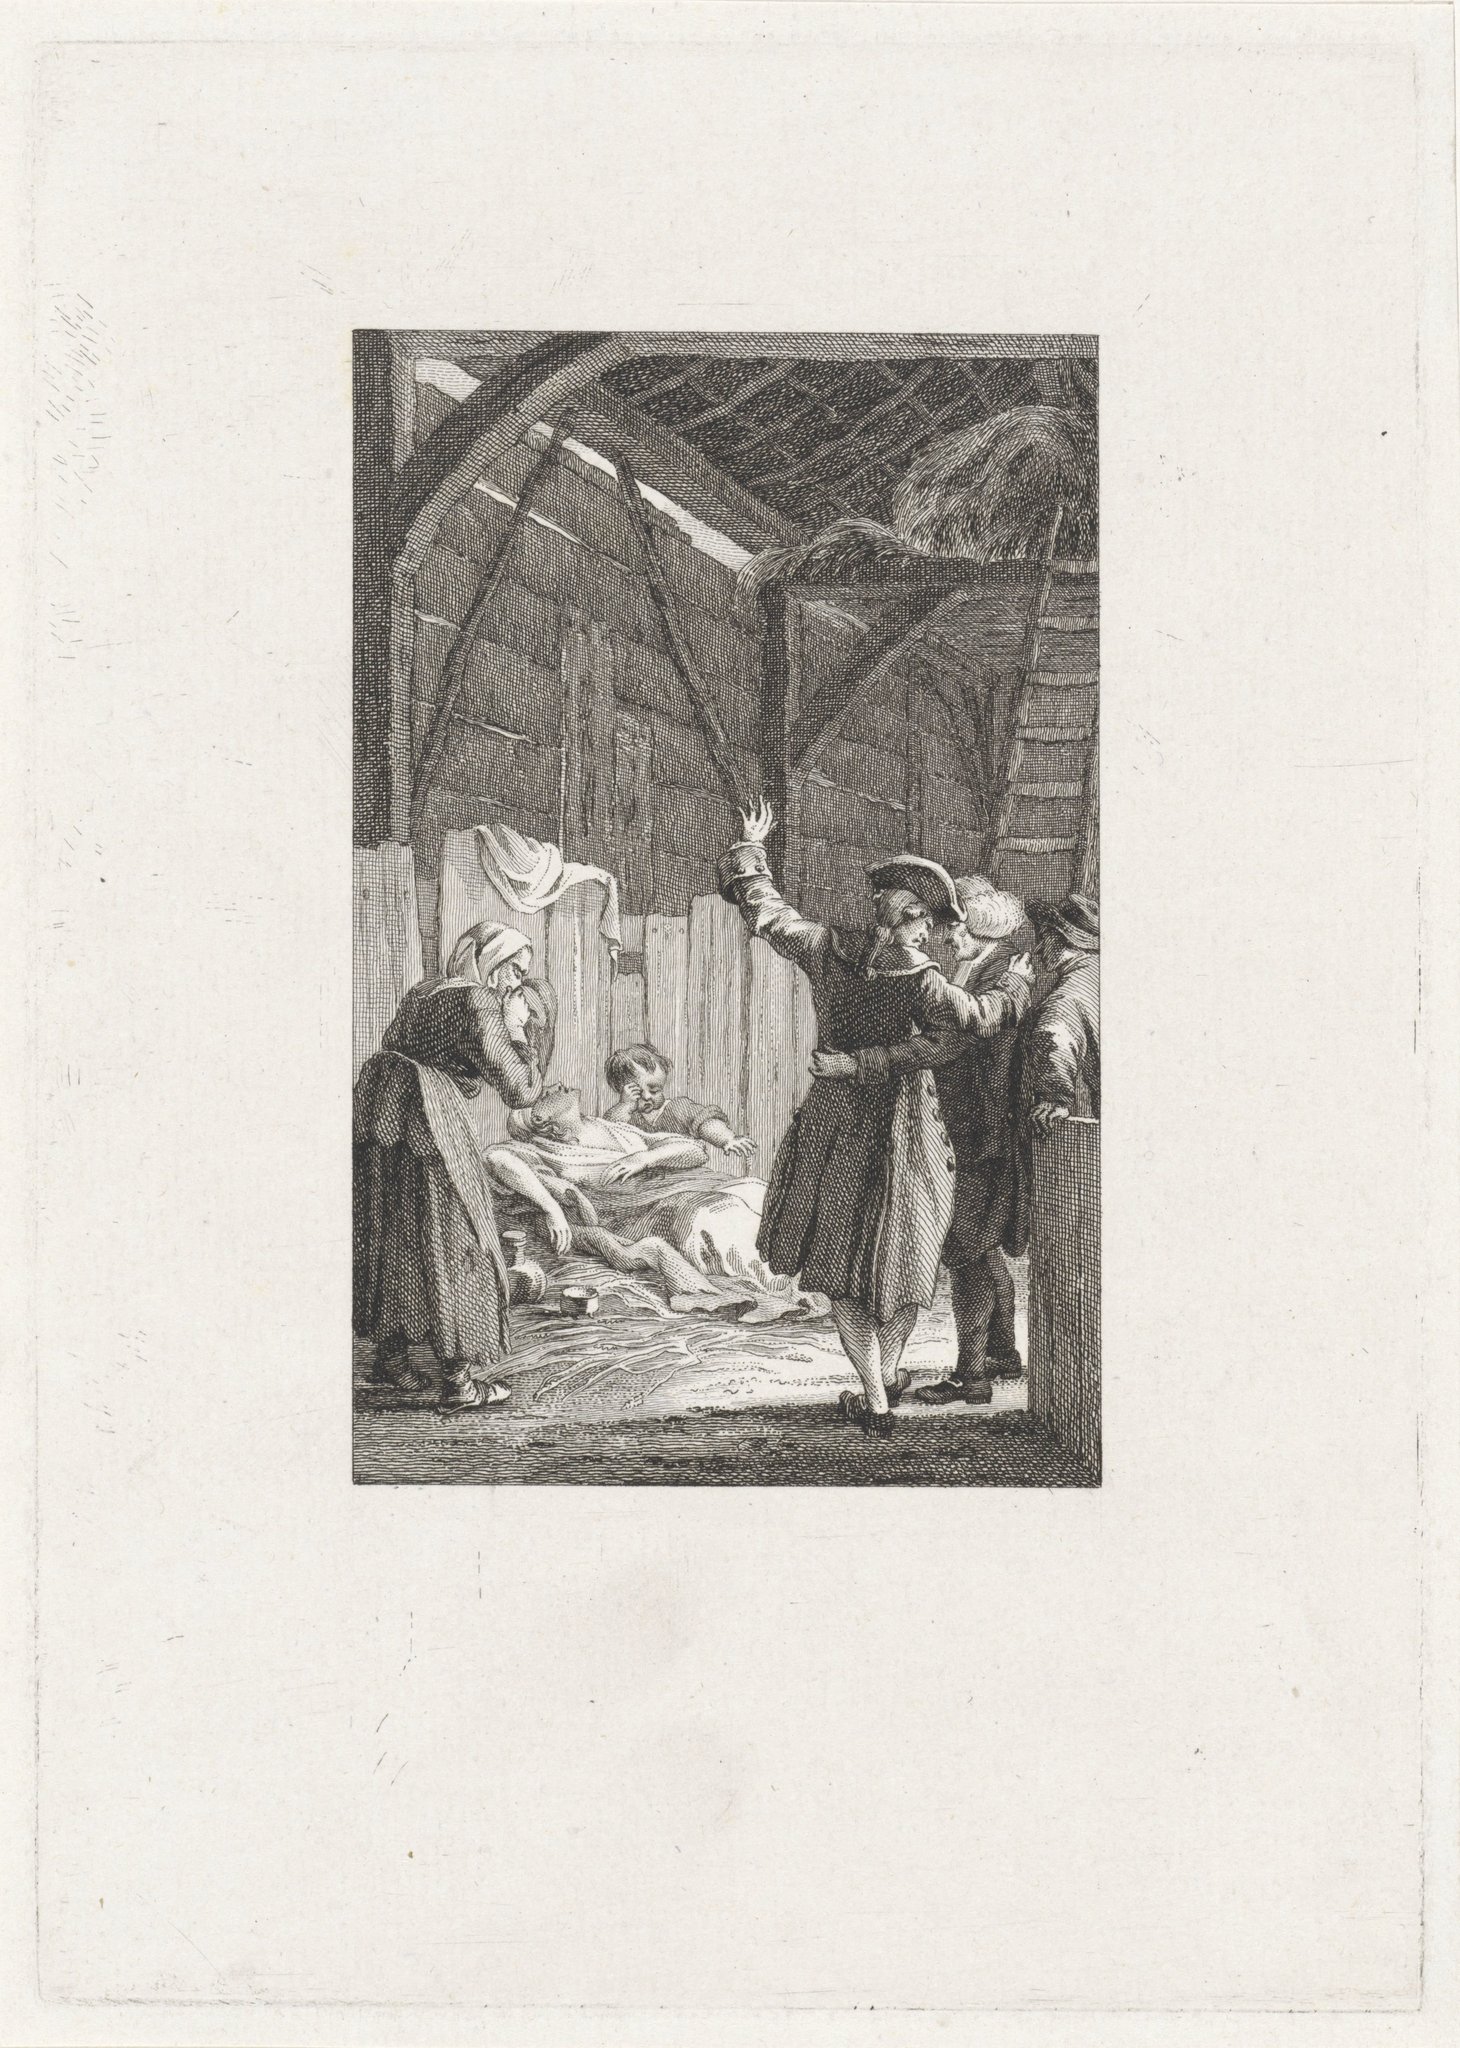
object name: print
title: Enkele figuren bij een dode vrouw in een schuur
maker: reinier vinkeles (i)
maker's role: draughtsman, print maker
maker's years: 1741-1816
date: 1780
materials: paper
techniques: engraving, etching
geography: amsterdam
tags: barn, weeping, death of human being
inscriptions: collector's mark: Lugt 2228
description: Proefdruk van een prent die ook gebruikt is als illustratie bij het verhaal 'Arabella' voor: Baculard d'Arnaud, F.T.M. de. Zedelijke verhaalen, deel 5. Amsterdam: A. Mens Jansz. en A.E. Munnikhuisen, 1780.